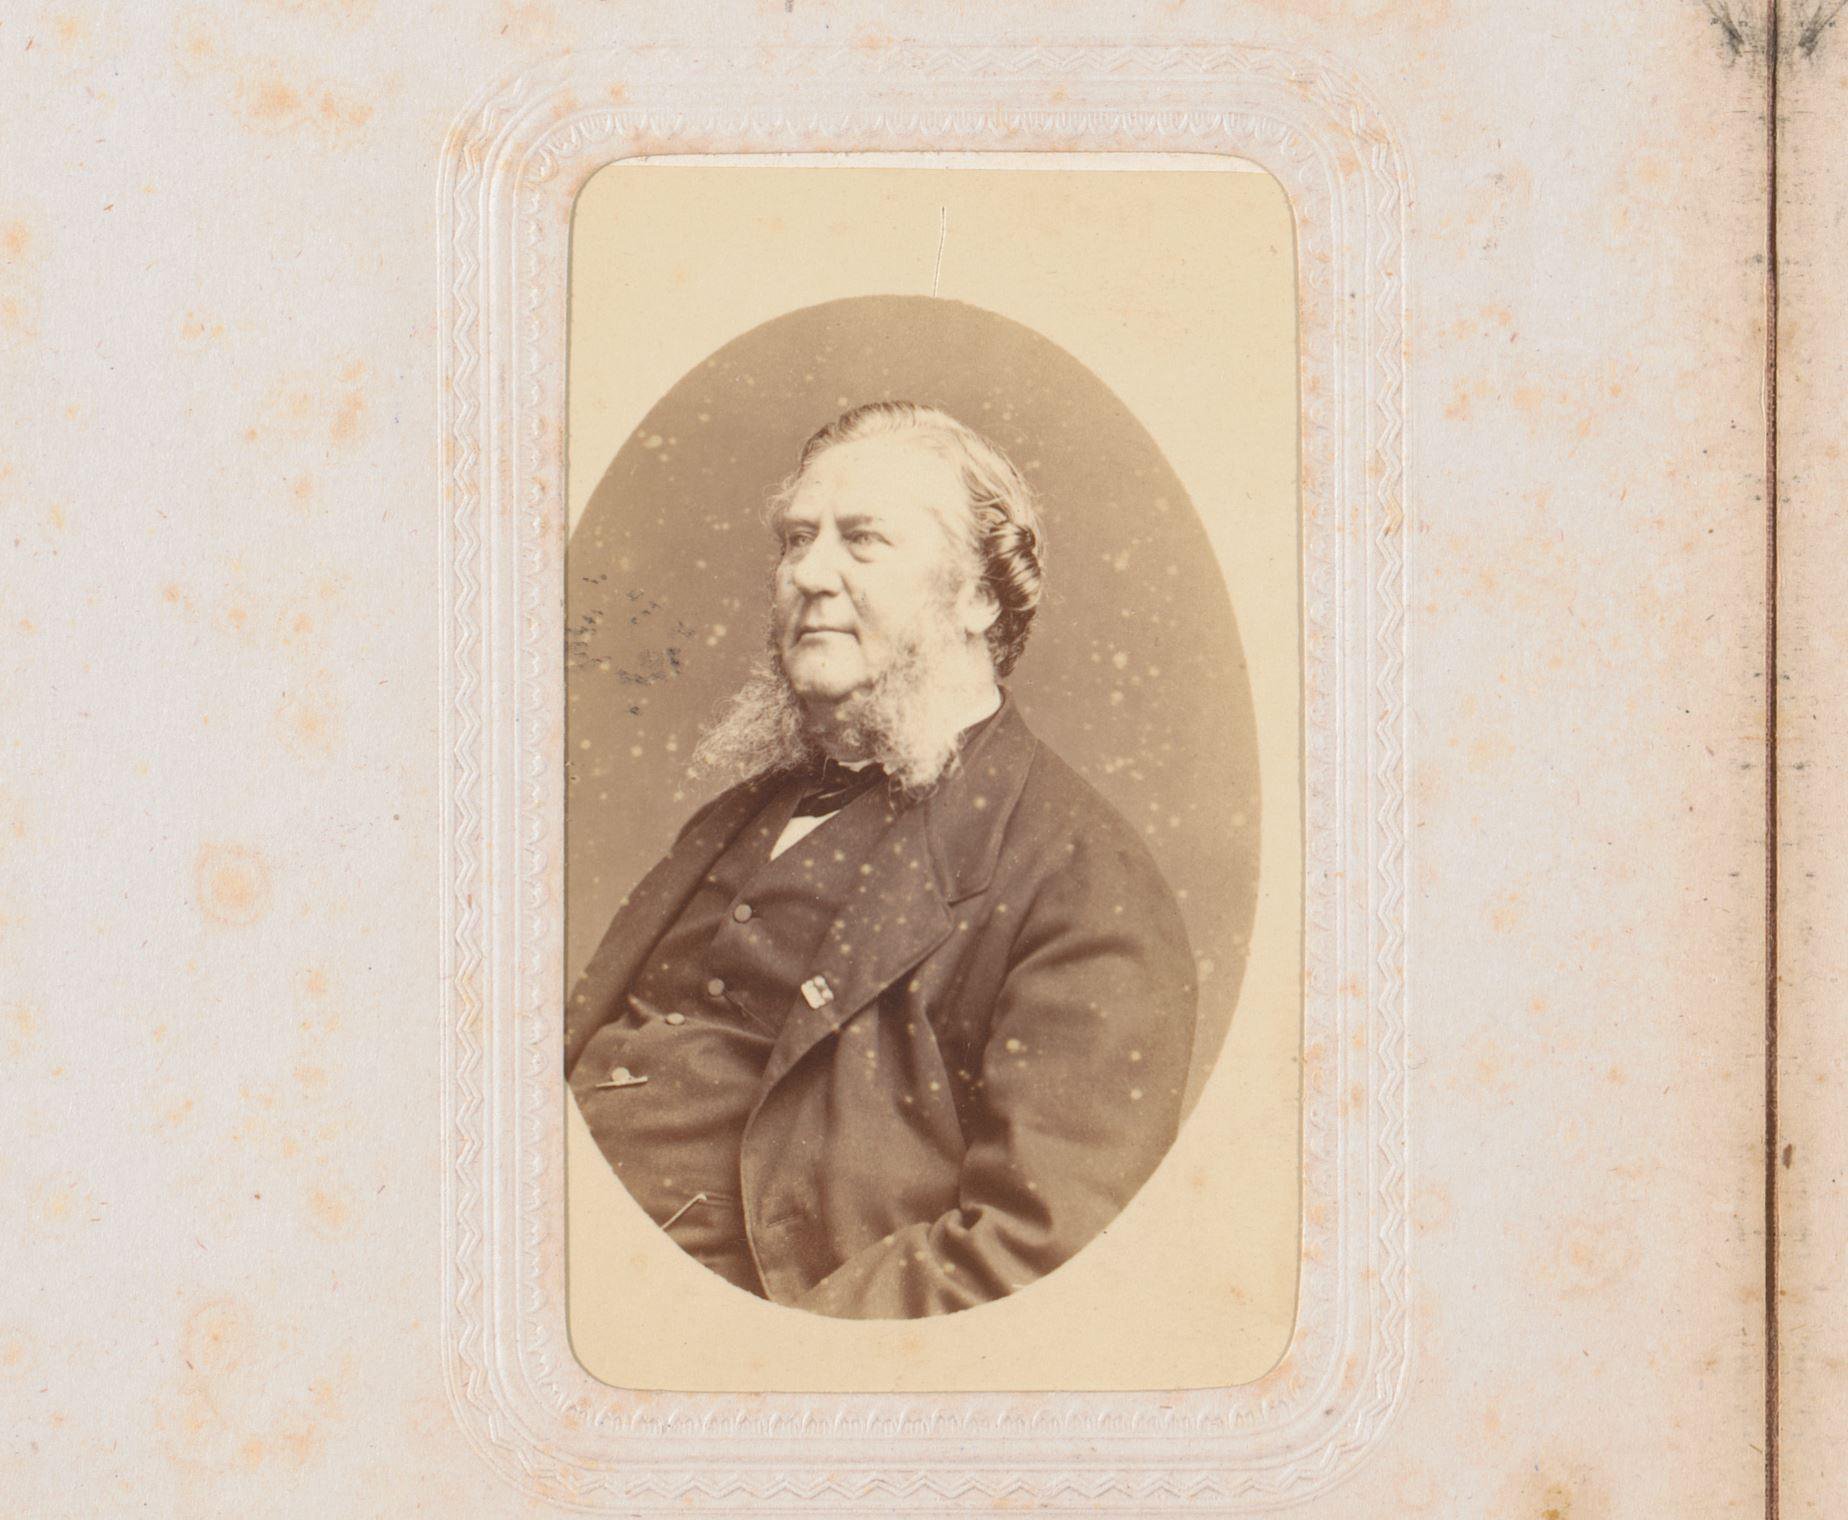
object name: carte de visite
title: Portret van een zittende man, aangeduid als O.A. Uhlenbeck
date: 1867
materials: cardboard, photographic support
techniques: albumen print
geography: amsterdam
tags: sitting figure, historical persons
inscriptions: name: ‘Ulenbeek’, inscription: ‘PHOTOGr ATELIER/ WEGNER & MOTTU,/ KALVERSTRAAT/ Over den Heyligenweg D. 26/ AMSTERDAM’, annotation: ‘21 September 1867./ O.A. Uhlenbeek’